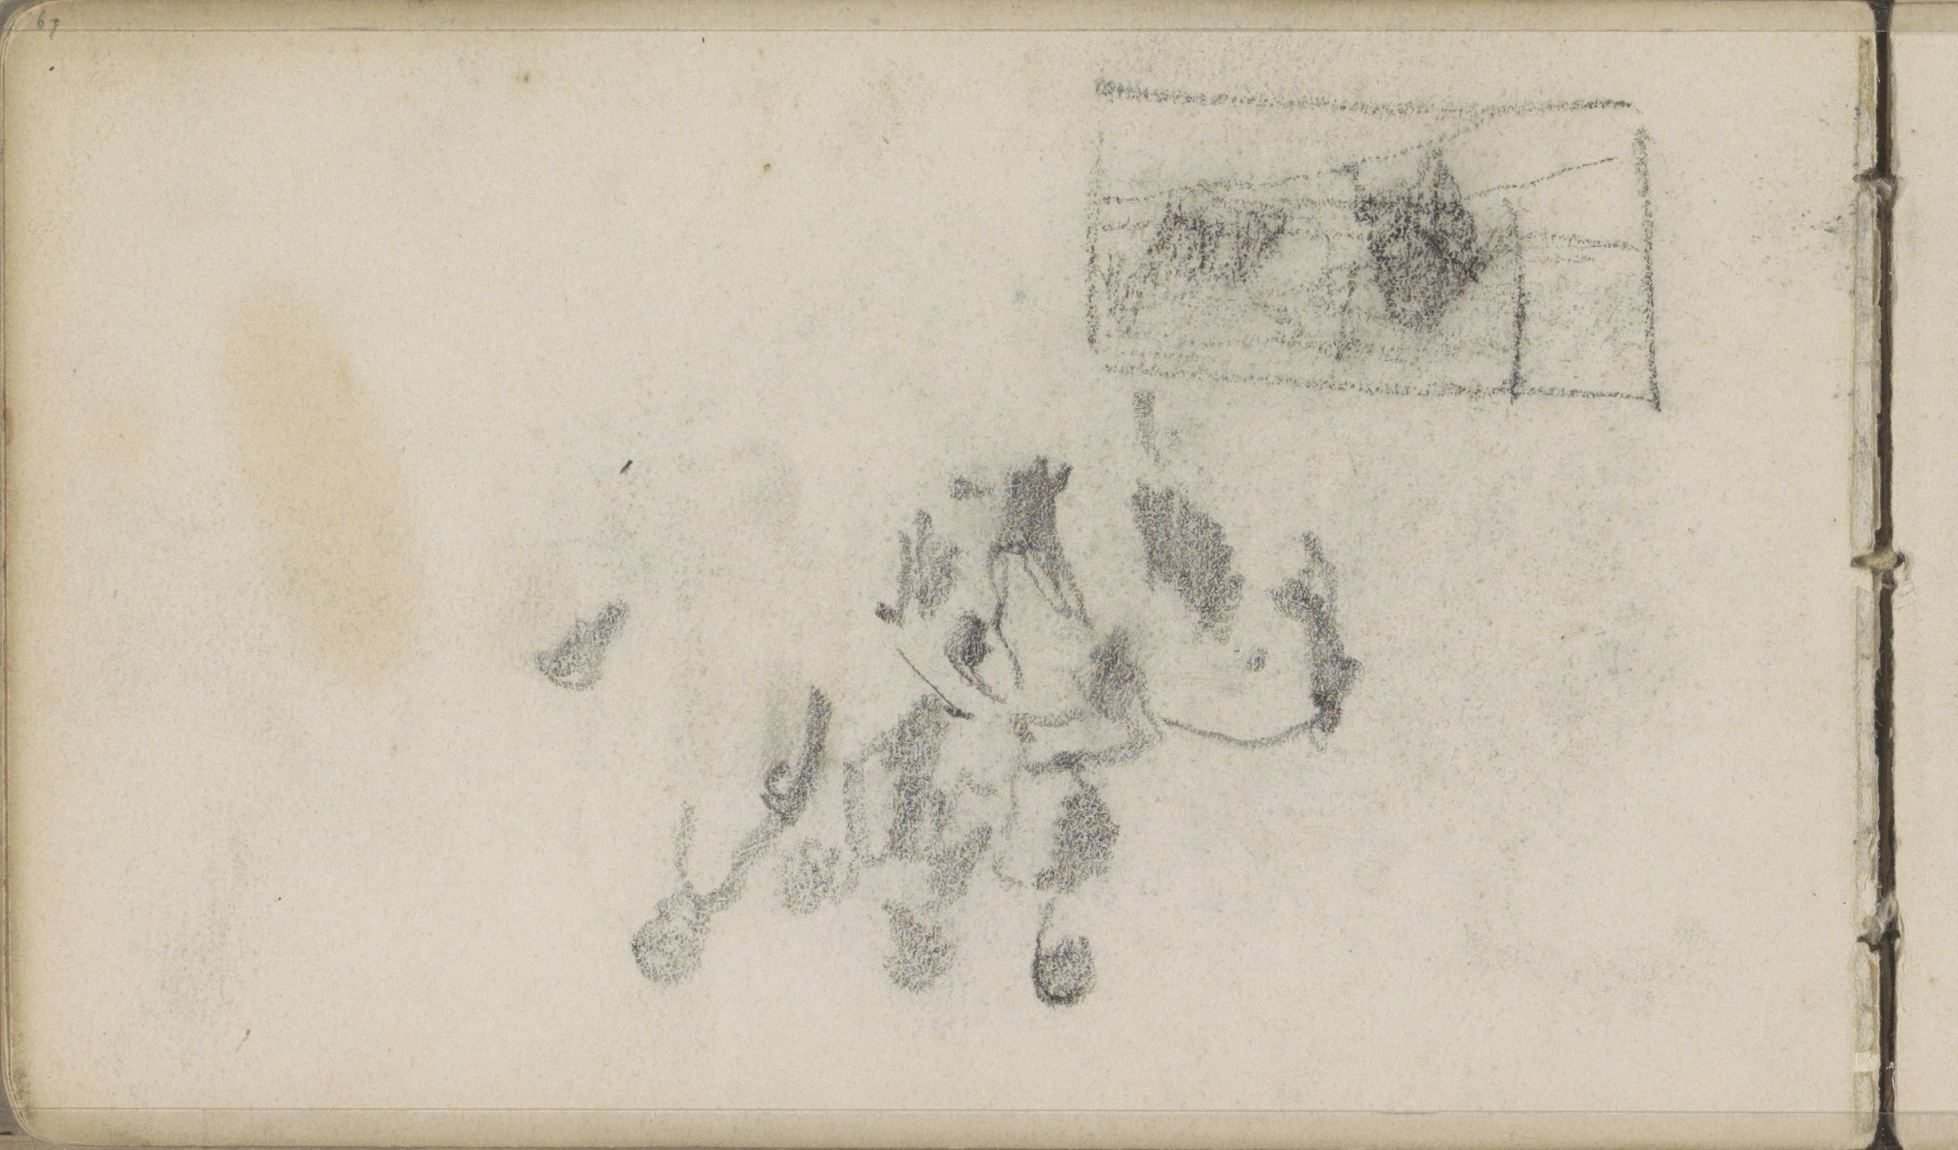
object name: sketchbook leaf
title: Ruiters en een compositiestudie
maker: george hendrik breitner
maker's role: draughtsman, painter, print maker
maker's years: 1857-1923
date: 1881-1883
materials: chalk, paper, pencil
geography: north brabant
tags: riding a horse, ass, or mule; rider, horseman, the soldier; the soldier's life (+ cavalry, horsemen)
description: De ruiters zijn mogelijk cavaleristen. Pagina 67 uit een schetsboek met 42 bladen.